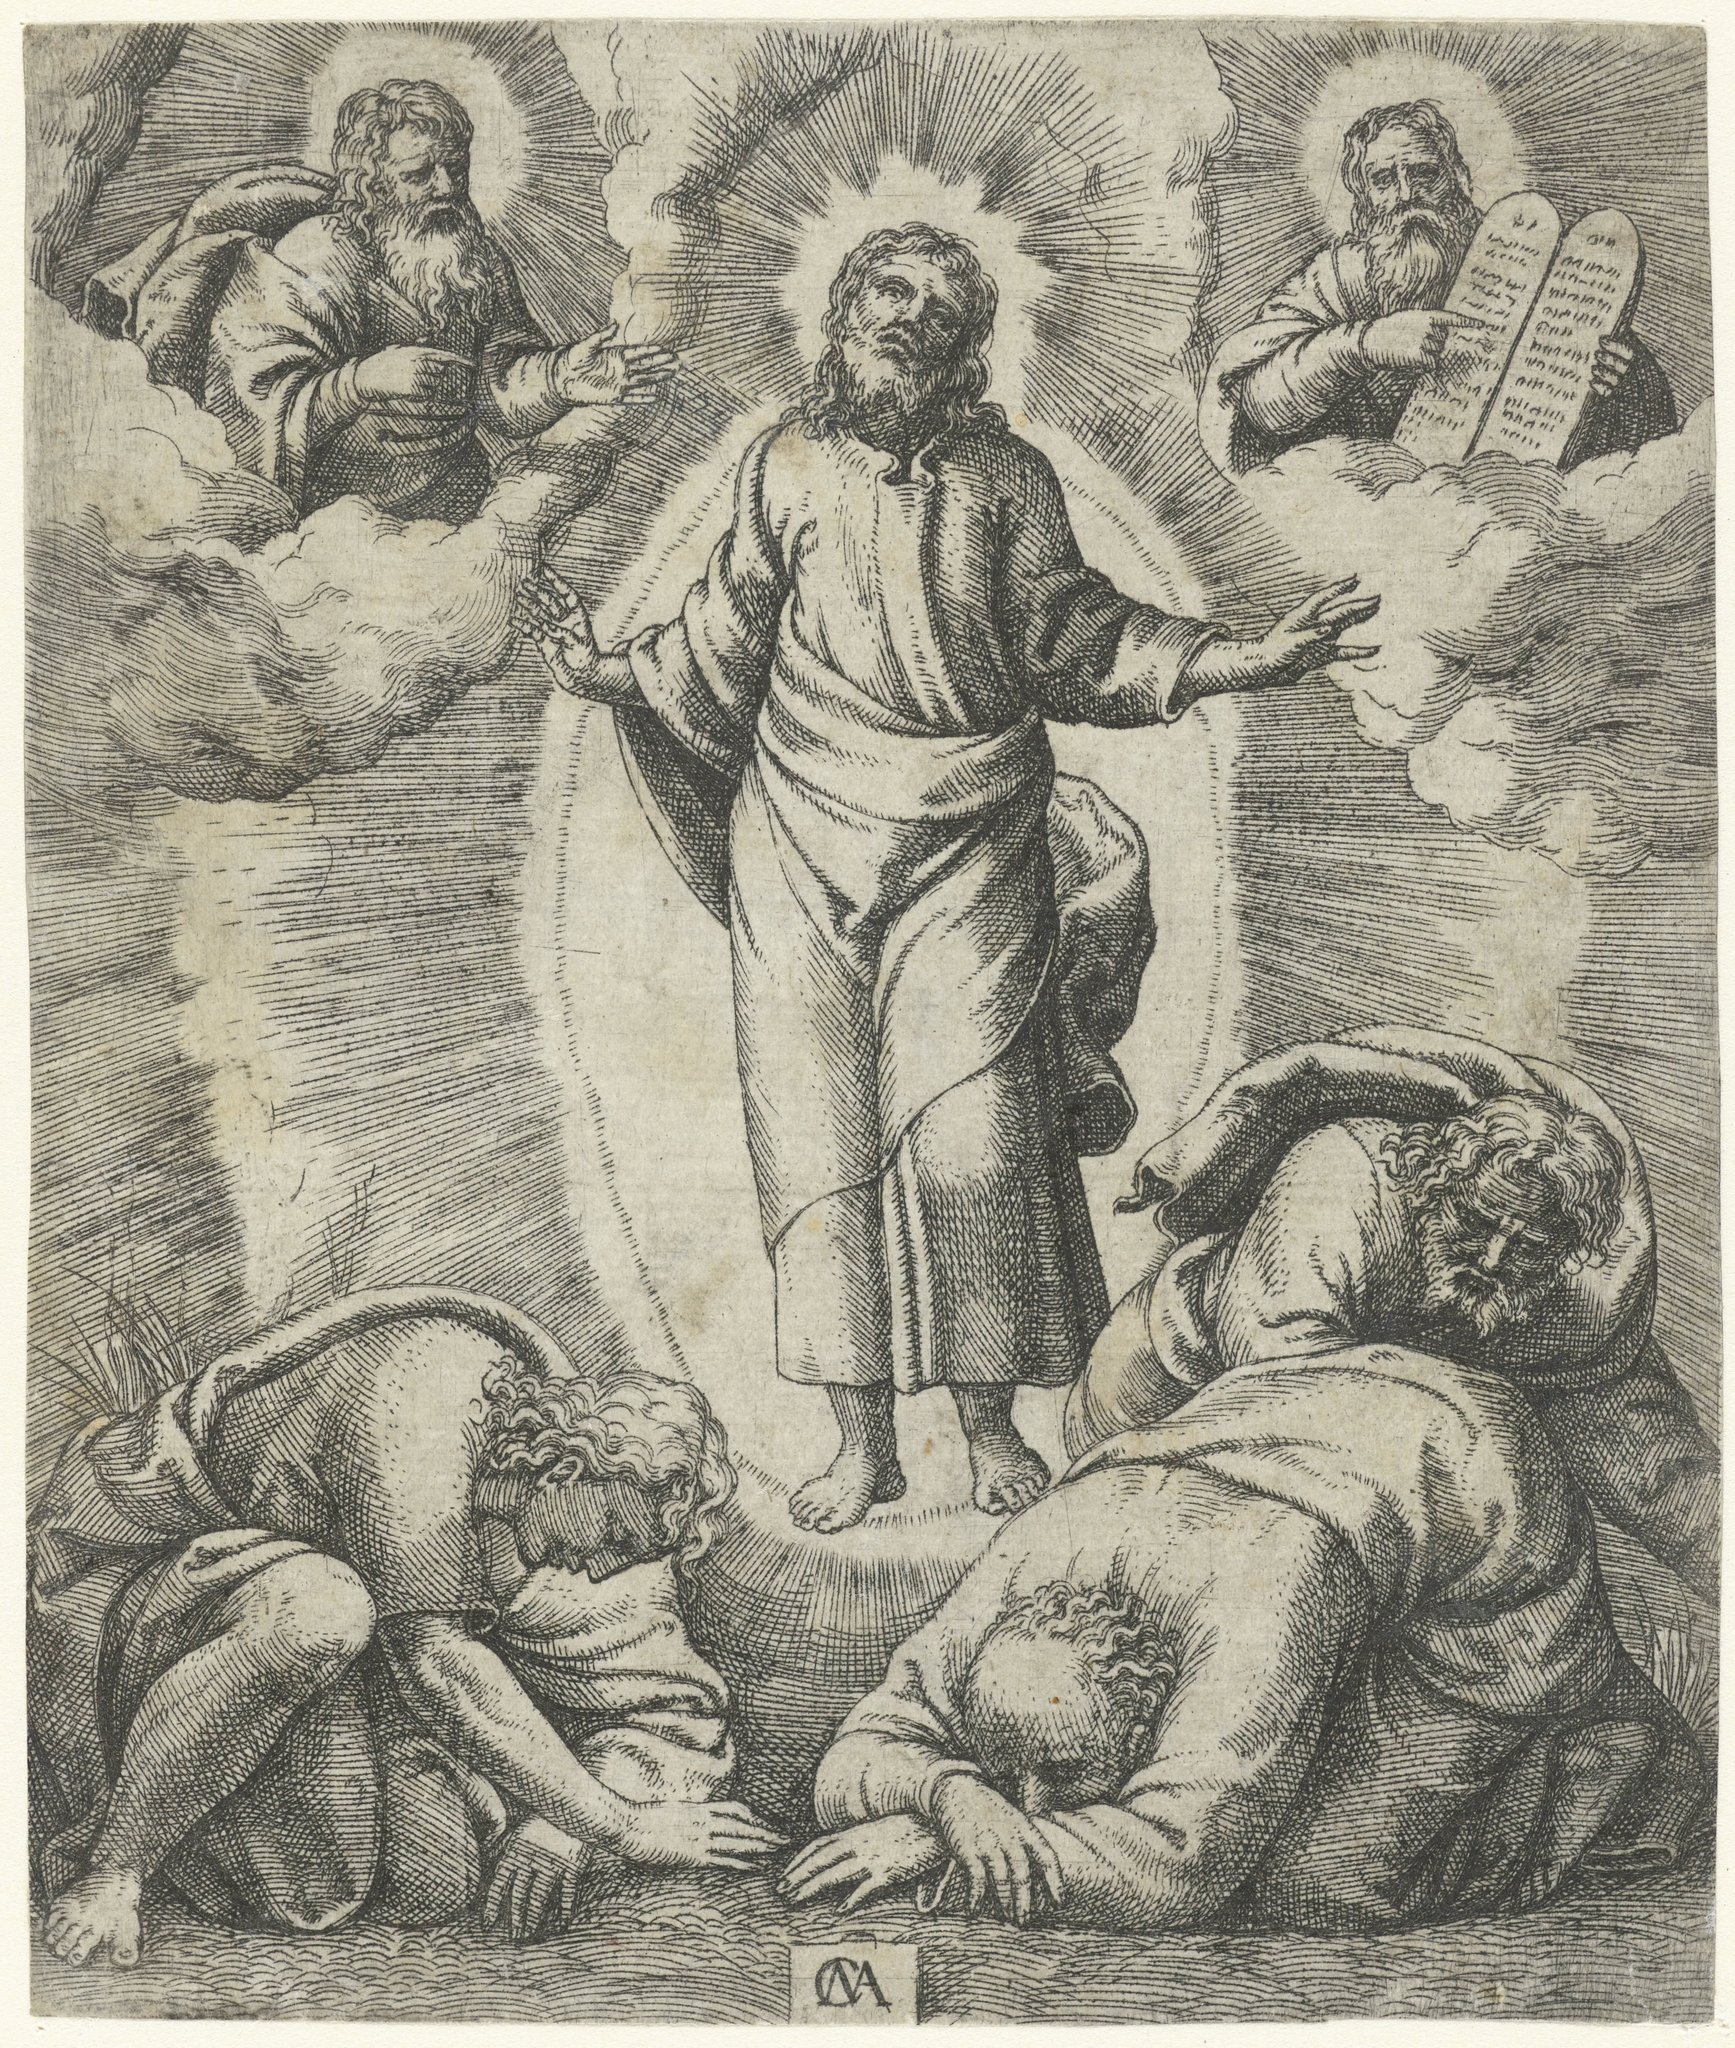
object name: print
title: Transfiguratie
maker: cornelis massijs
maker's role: painter, print maker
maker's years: 1510-1557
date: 1544-1556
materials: paper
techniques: engraving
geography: antwerp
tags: the transfiguration: moses and elijah appear on either side of christ on mount tabor (matthew 17:1-13; mark 9:2-13; luke 9:28-36)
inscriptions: collector's mark: Lugt 240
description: Christus wordt omringd door een stralenkrans bij de verheerlijking op de berg. Zijn discipelen Petrus, Jakobus en Johannes knielen voor hem. In de bovenhoeken de verschijningen van Elia en Mozes met de tafelen der wet.